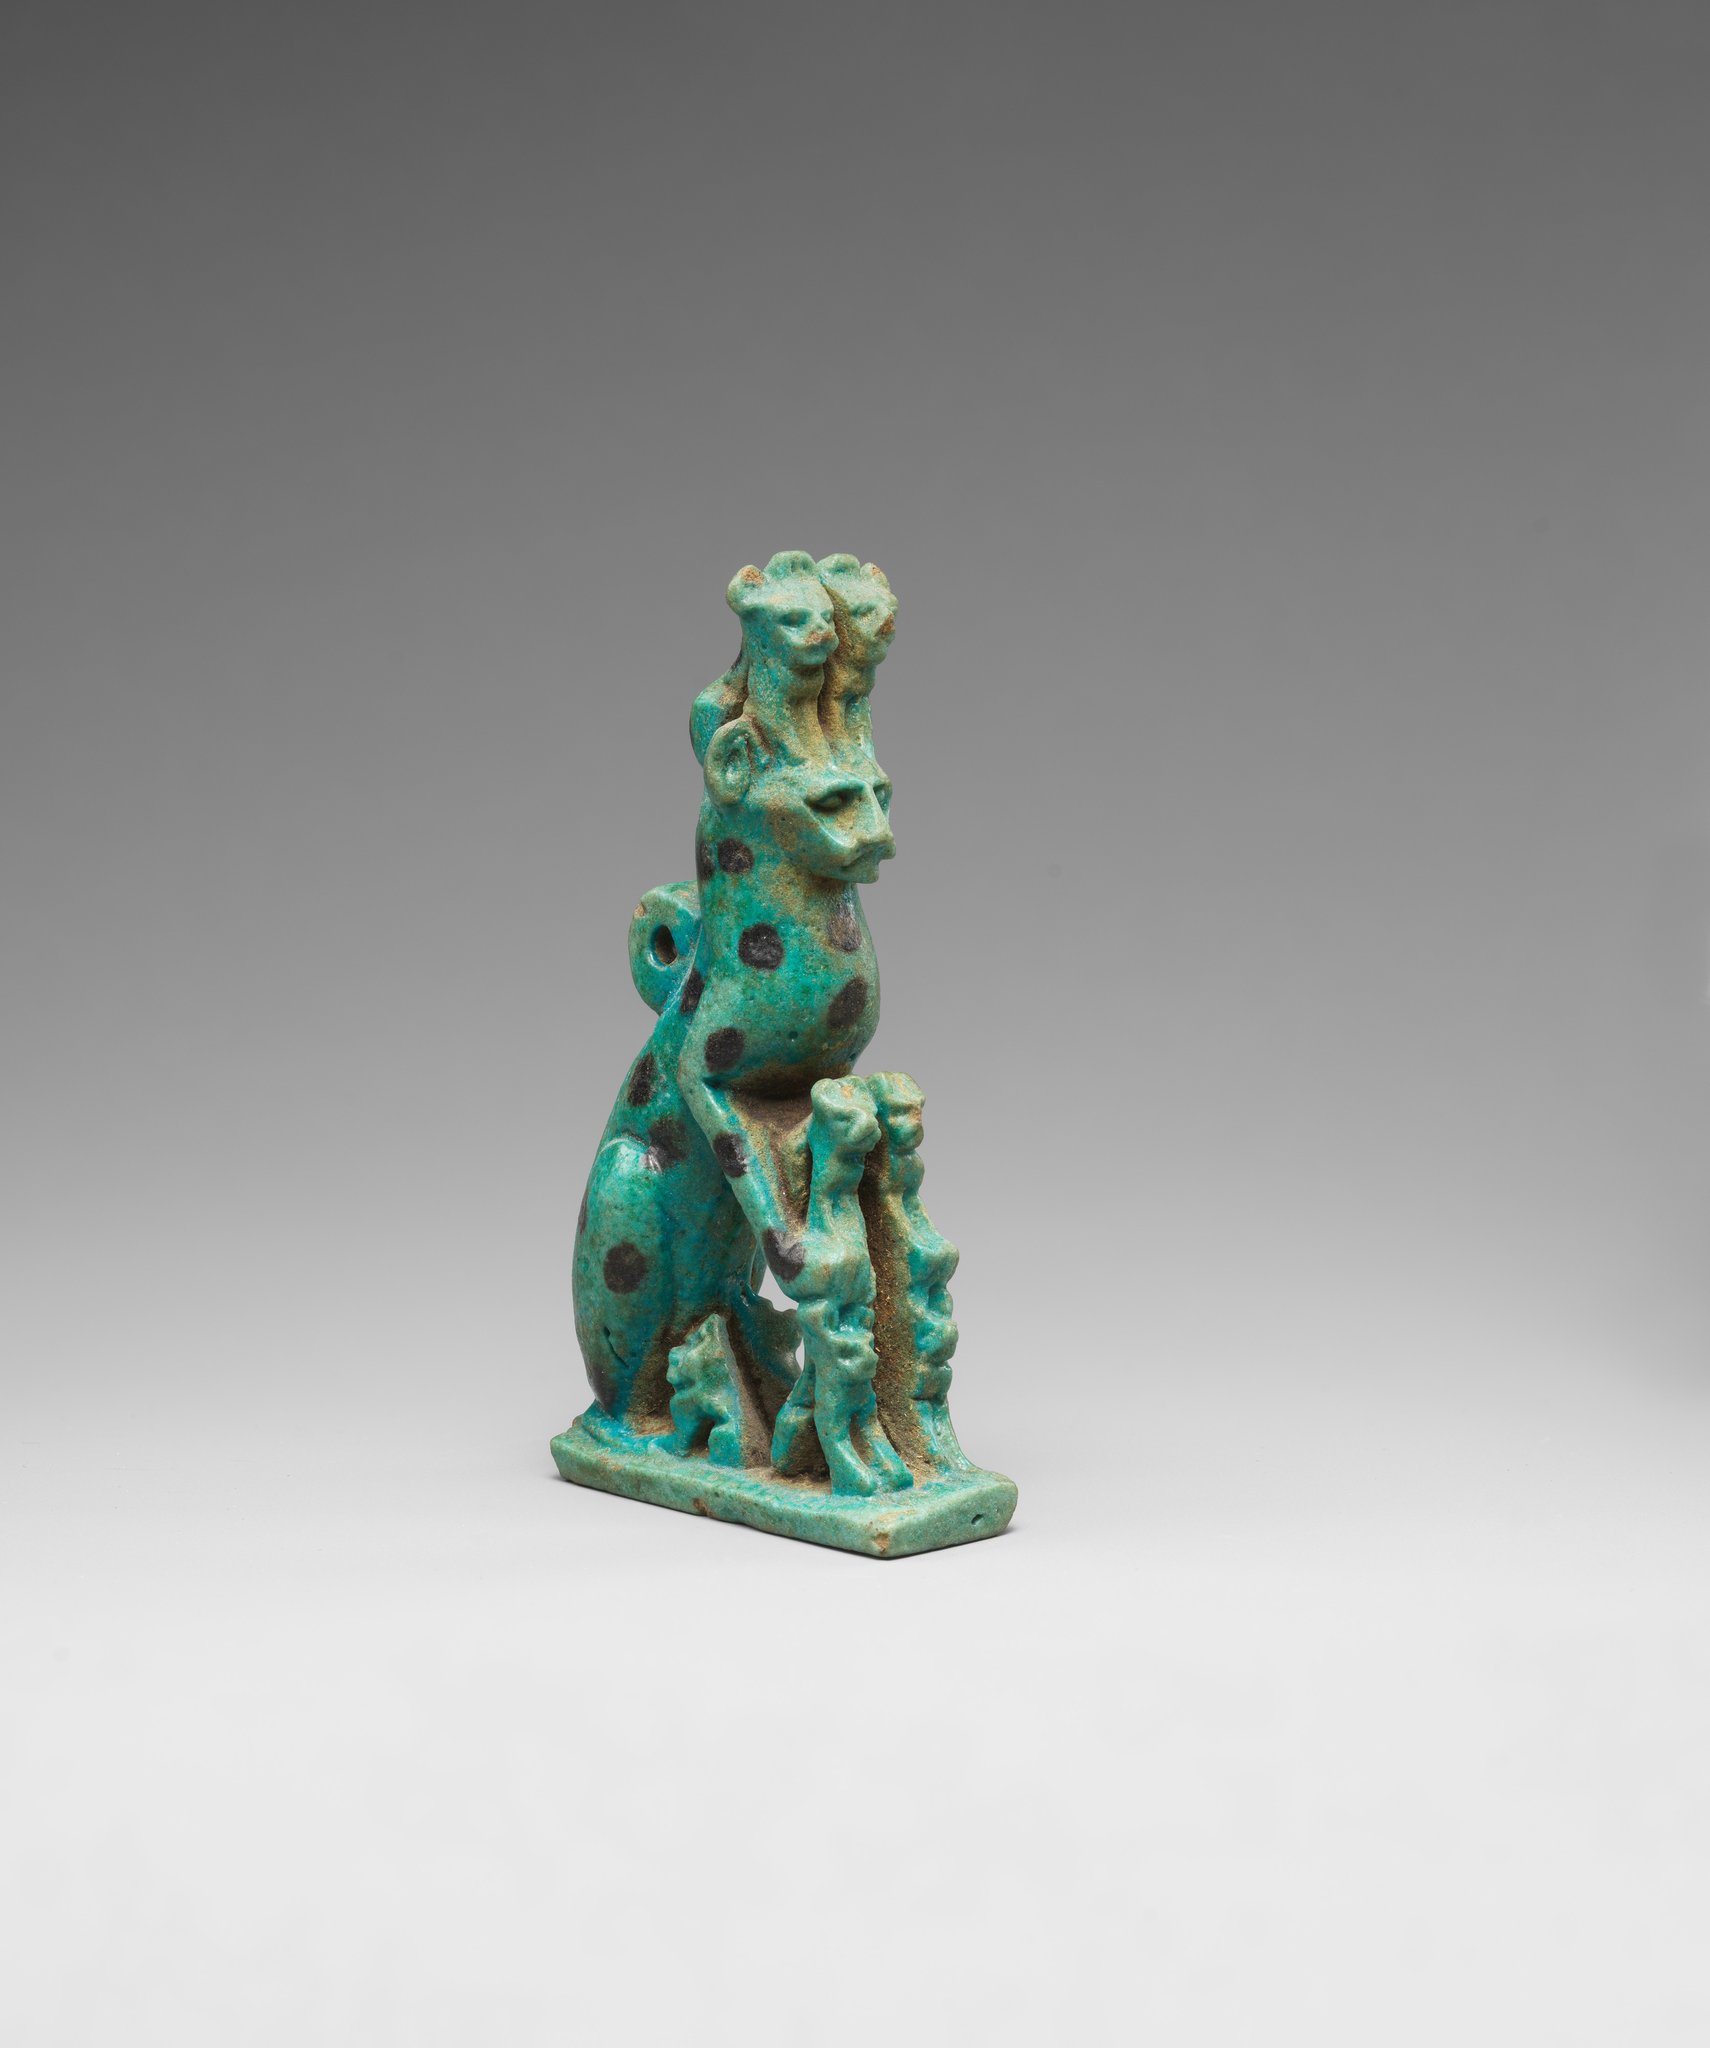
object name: amulet, cat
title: Figurine of a cat with kittens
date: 1070-664 BCE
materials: faience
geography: egypt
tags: cats